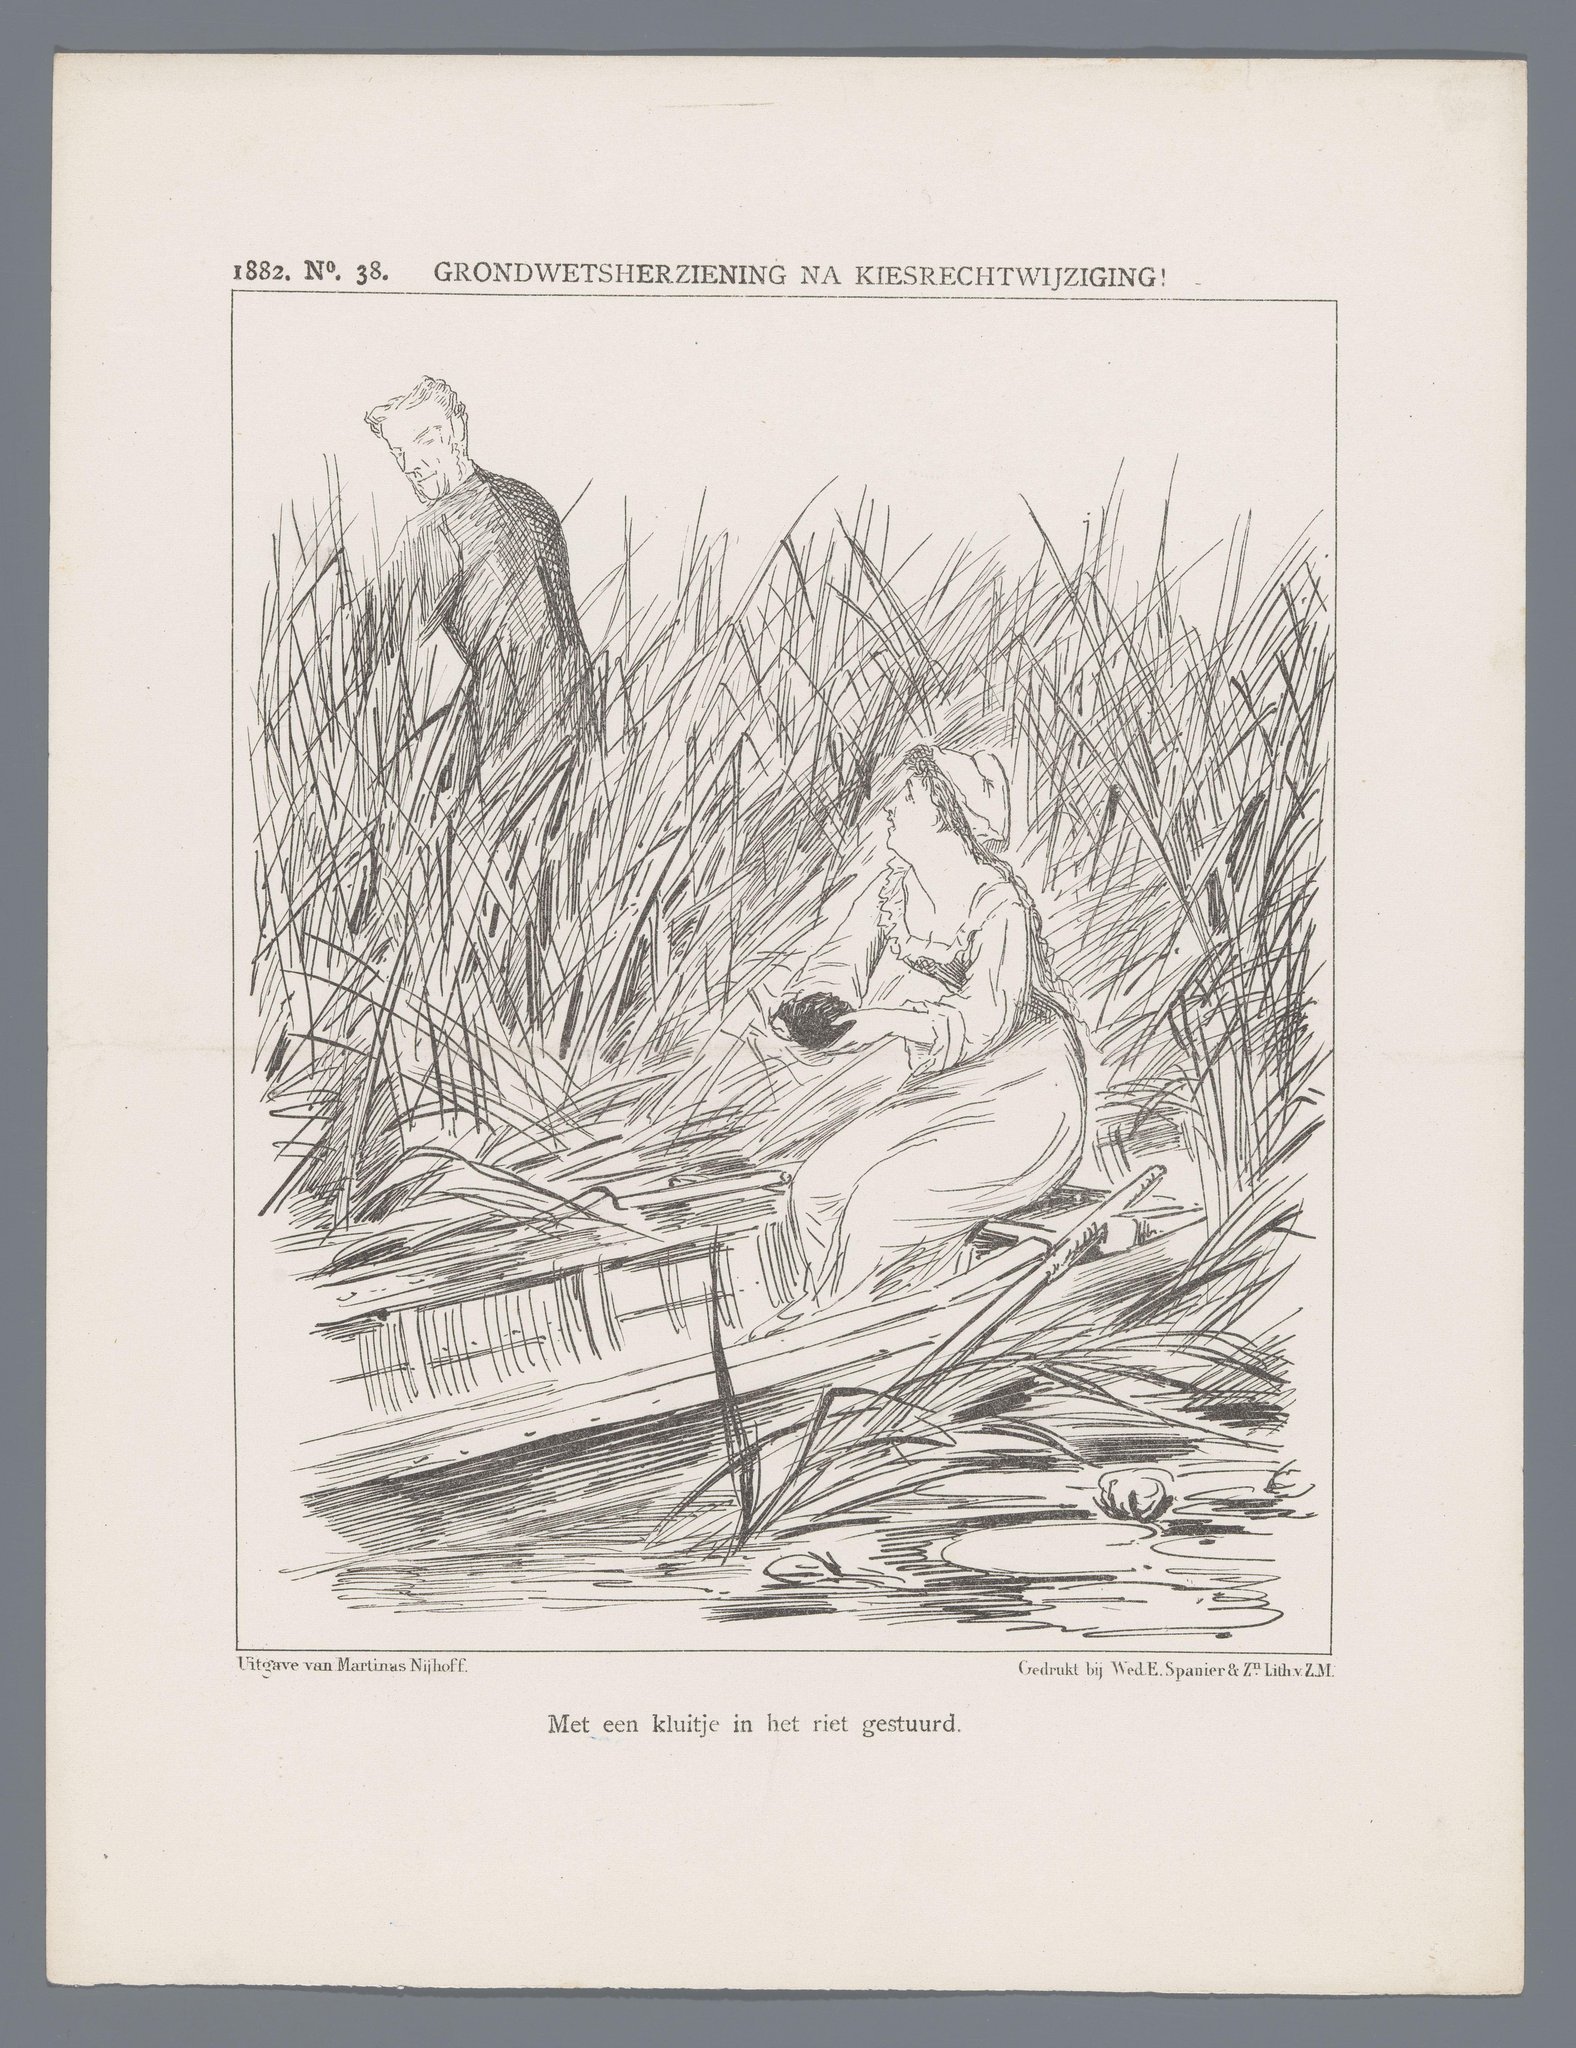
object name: cartoon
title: Grondwetsherziening na kiesrechtwijziging!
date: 1882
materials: paper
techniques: lithograph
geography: netherlands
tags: personifications of countries, nations, states, districts, etc.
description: Politieke spotprent met de Nederlandse Maagd door minister van Lynden van Sandenburg met een kluitje in het riet gestuurd. Plaat verschenen bij het weekblad De Nederlandsche Spectator, nr. 38, 1882.